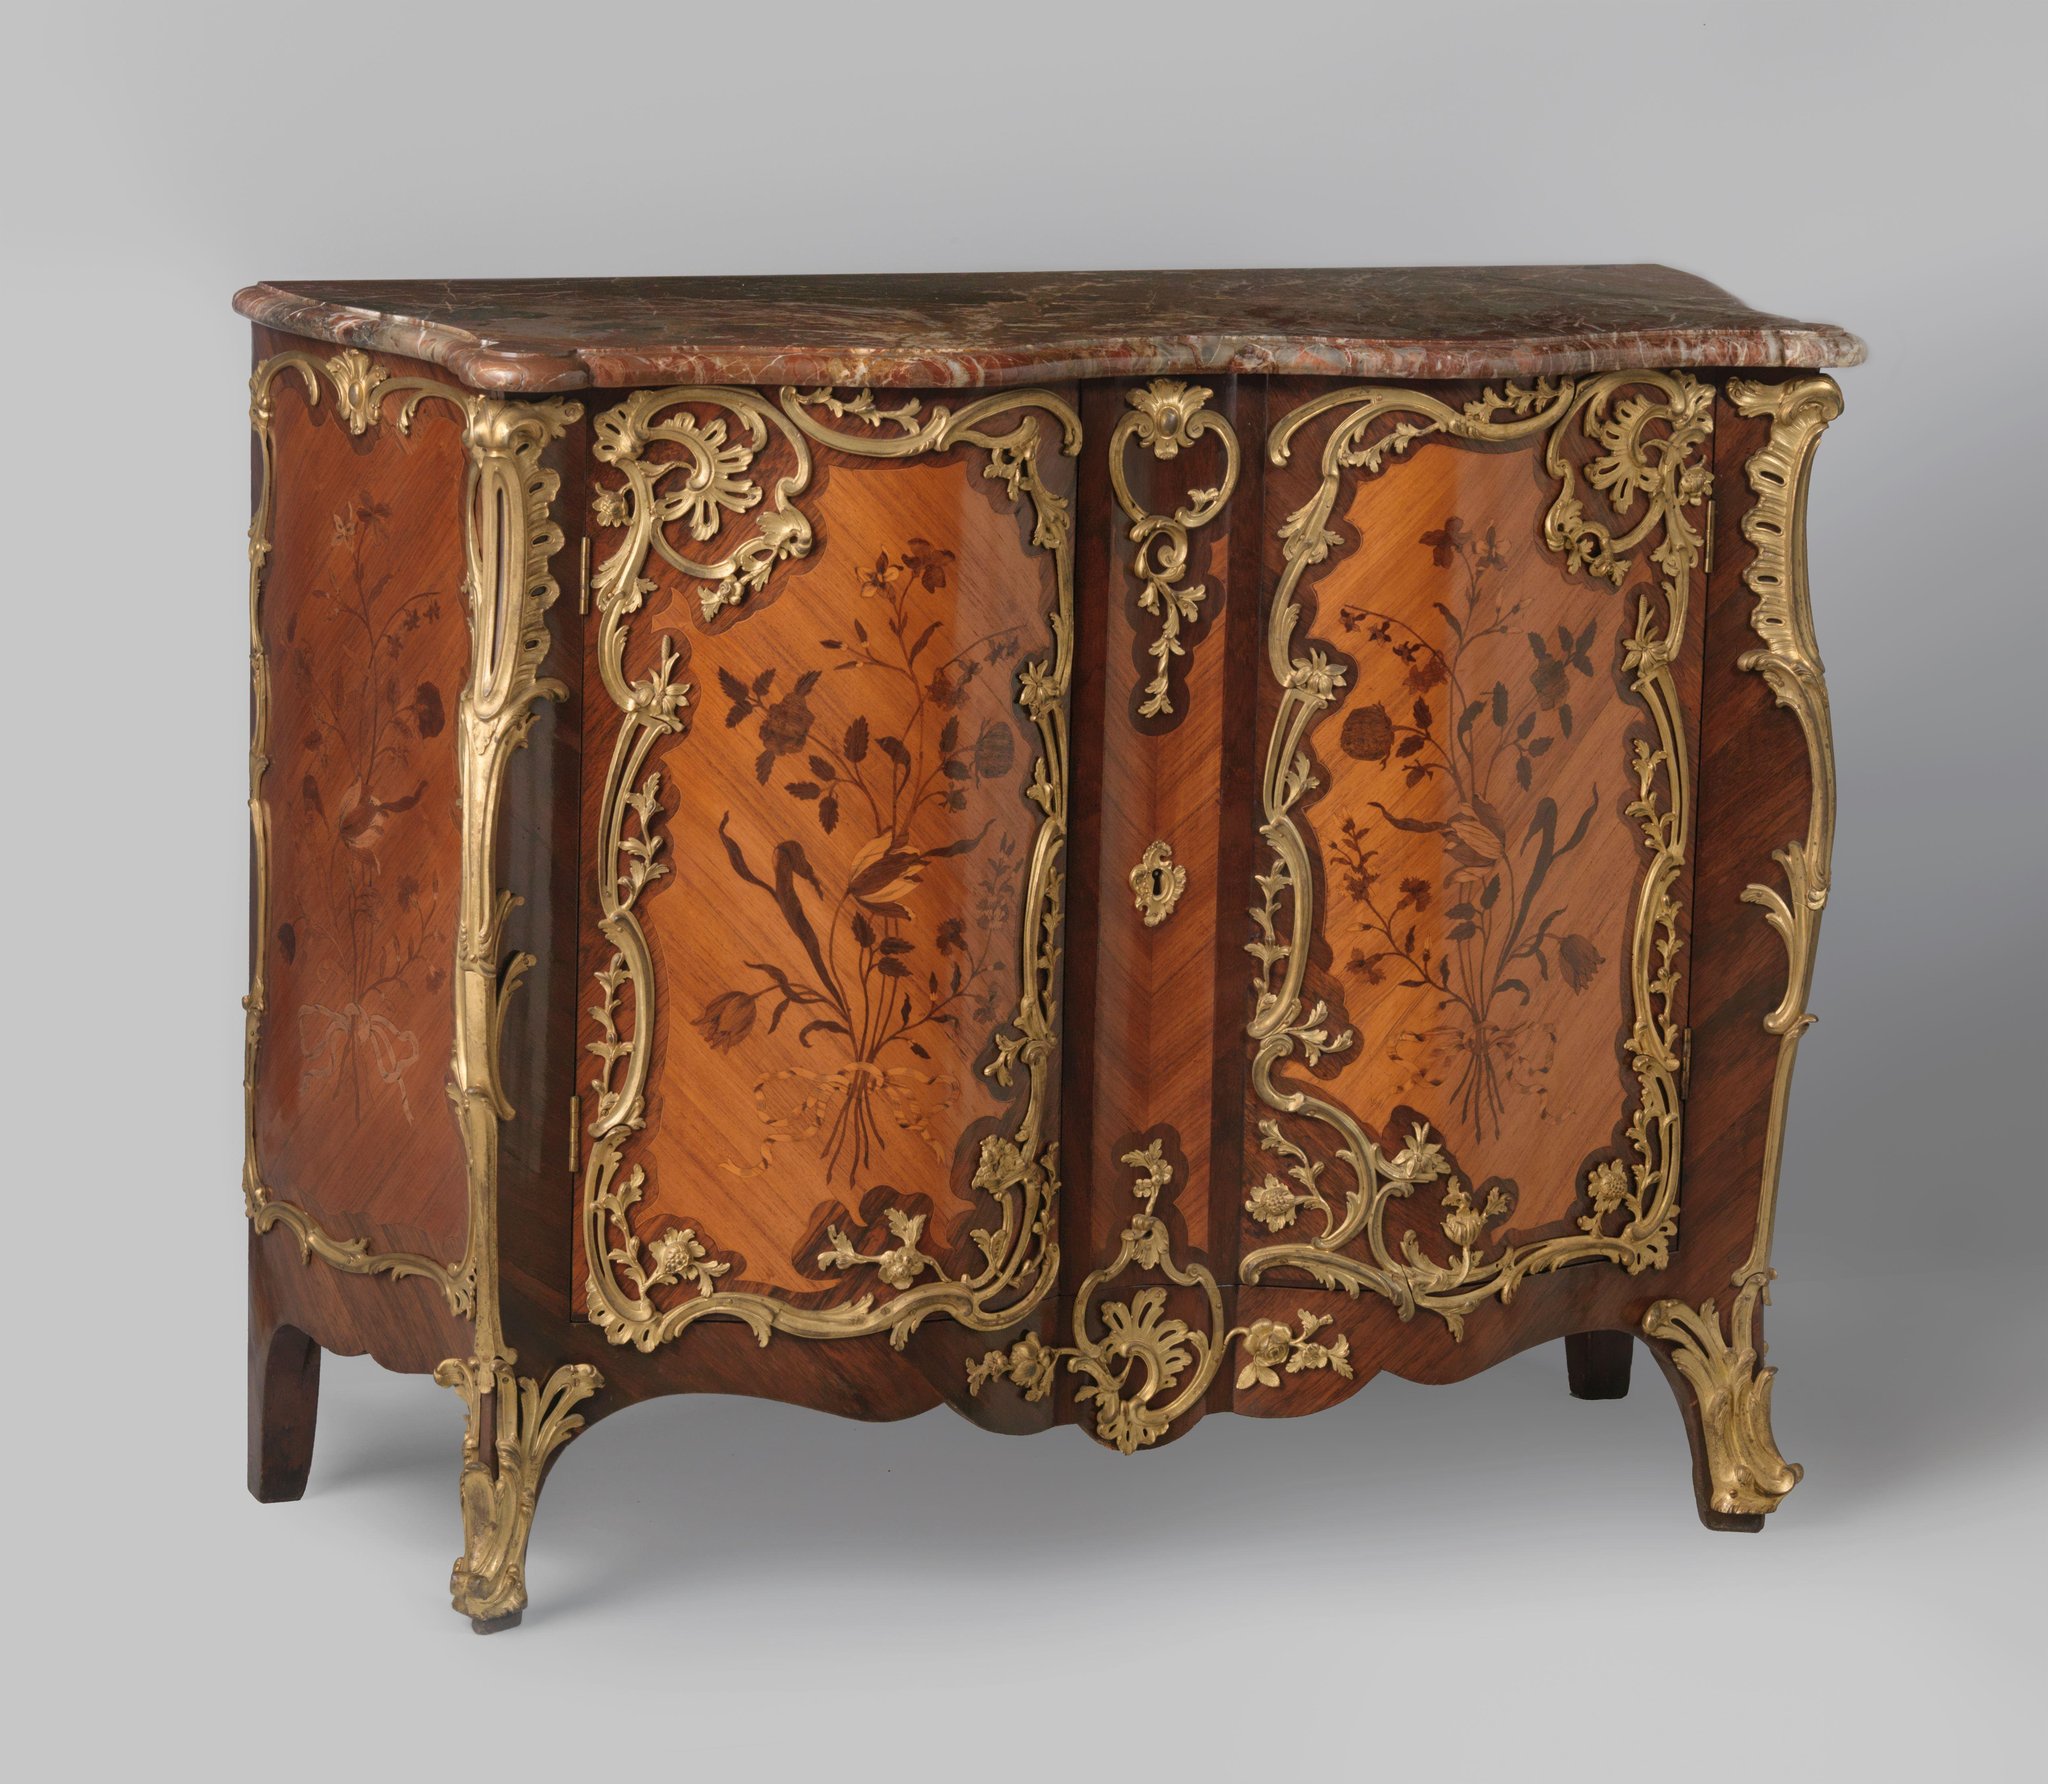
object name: case furniture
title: Kast, laag model, versierd met marqueterie en bronzen beslag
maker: boucher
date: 1750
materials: wood, bronze, marble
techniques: gilding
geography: france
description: Kast versierd met marqueterie van palissander- en rozehout en andere houtsoorten op eikenhouten kern. De S-vormige poten zijn overhoeks geplaatst en dragen beslag. Het front bestaat uit twee gebogen deuren, waartussen een geholde middenstijl, en heeft, evenals de gewelfde zijkanten, panelen in marqueterie binnen asymmetrisch verguld bronzen beslag. De panelen zijn versierd met door een strik samengebonden boeketten. Gestempeld: BVRB JME (wellicht Boucher); eigendomsmerk onder marmeren blad. Zie: BK-16679-a.